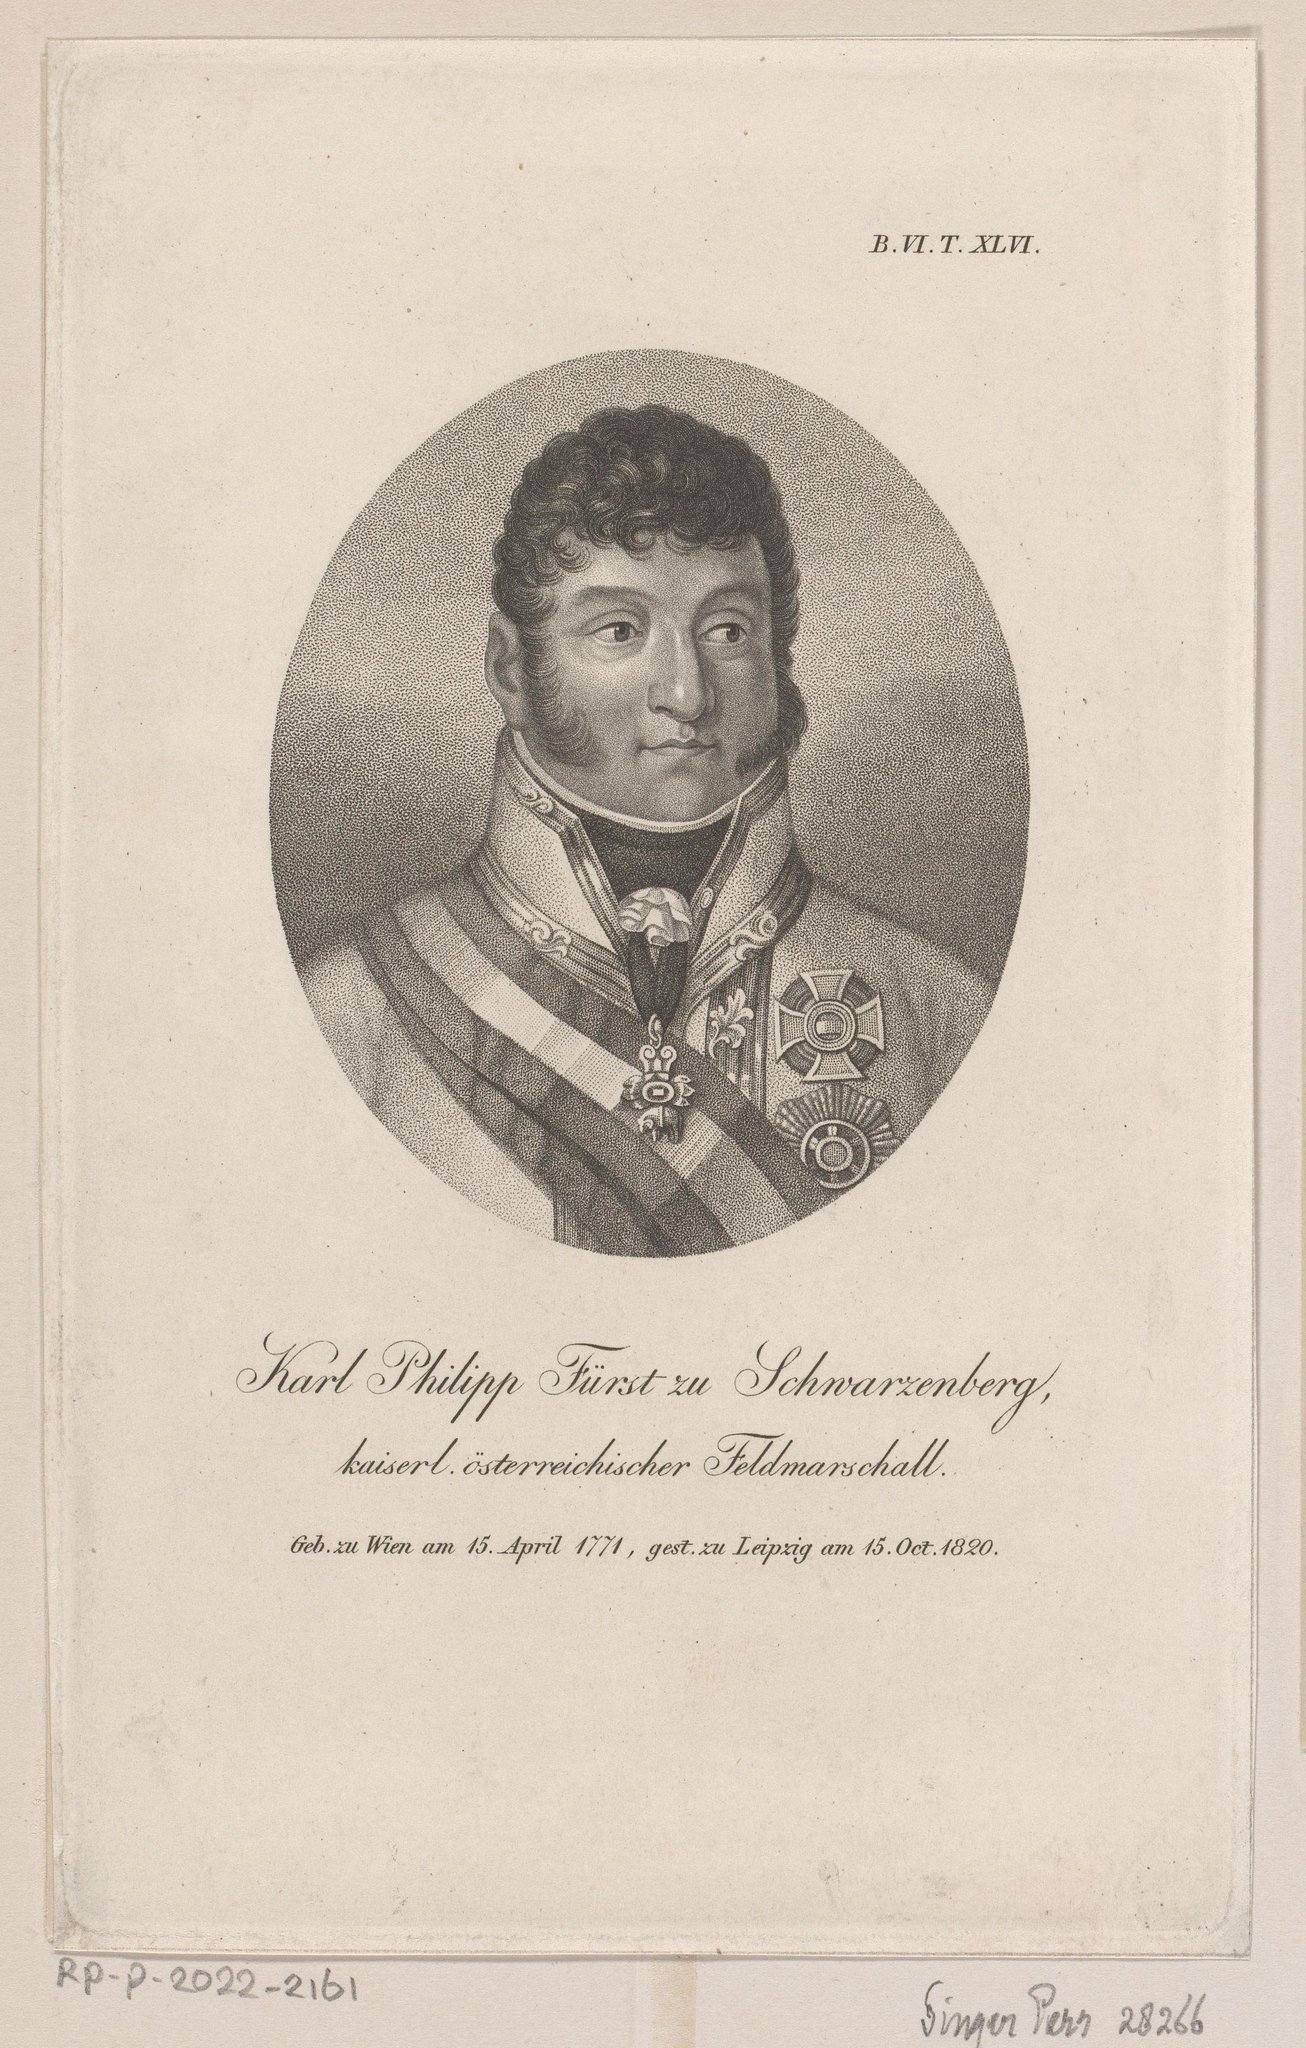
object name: print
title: Portret van Carl Philipp von Schwarzenberg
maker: Anonymous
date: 1820-1899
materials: paper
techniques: stippling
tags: commander-in-chief, general, marshal, historical persons, knighthood order of the golden fleece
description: Met drieregelig onderschrift in het Duits. Rechtsboven: B. VI. T. XLVI.